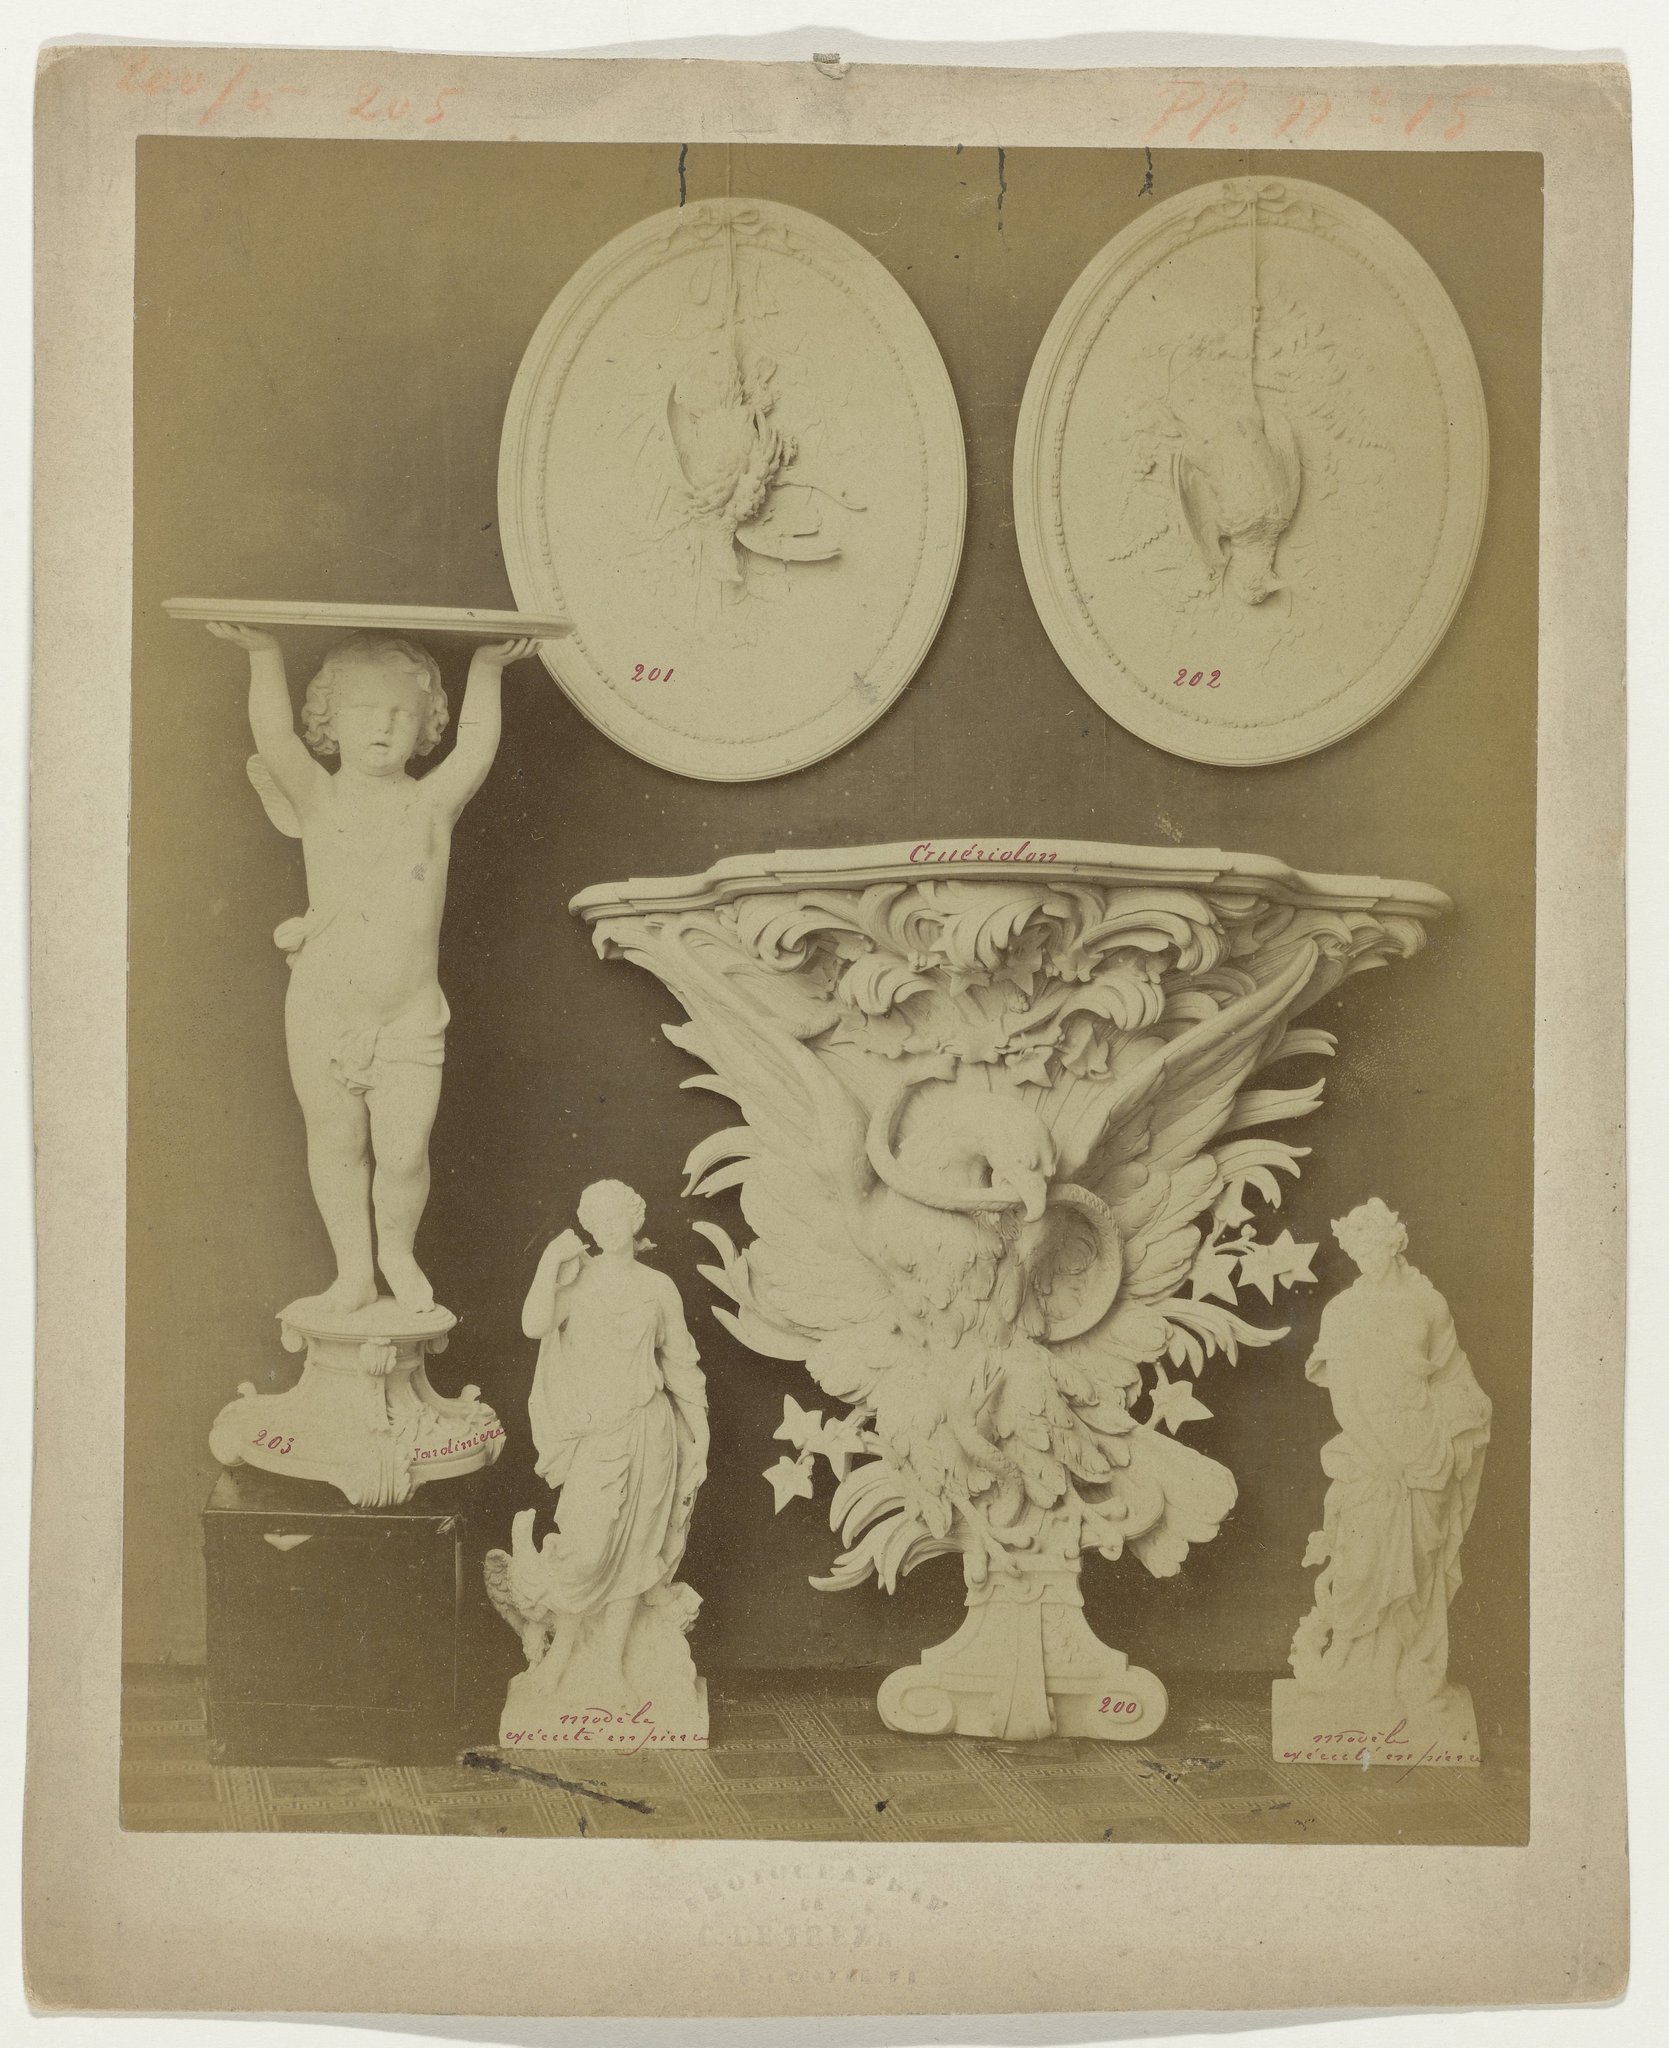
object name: photograph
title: Compositie van gipsen ornamenten uit het atelier van J. Delbove, Brussel, België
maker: charles de trez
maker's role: painter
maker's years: 1822-1899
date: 1860-1882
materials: cardboard, paper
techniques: albumen print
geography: brussels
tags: piece of sculpture, reproduction of a piece of sculpture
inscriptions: number, inscription: ‘200 à 205 PP. No. 15’, inscription, address: ‘PHOTOGRAPHIE/ DE/ C. DE TREZ &/ RUE DU PONT NEUF 1’, check stamp: ‘J.H DELBOVE/ Rue de Malines, 37/ BRUXELLES’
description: Foto uit een incomplete serie van 13 foto's. Foto heeft sporen van een oogje aan de bovenzijde waaruit blijkt dat de foto gehangen heeft. Recto op de foto in rode pen nummers per afgebeeld gipsen voorwerp, corresponderend met een handgeschreven lijst die verso is geplakt.